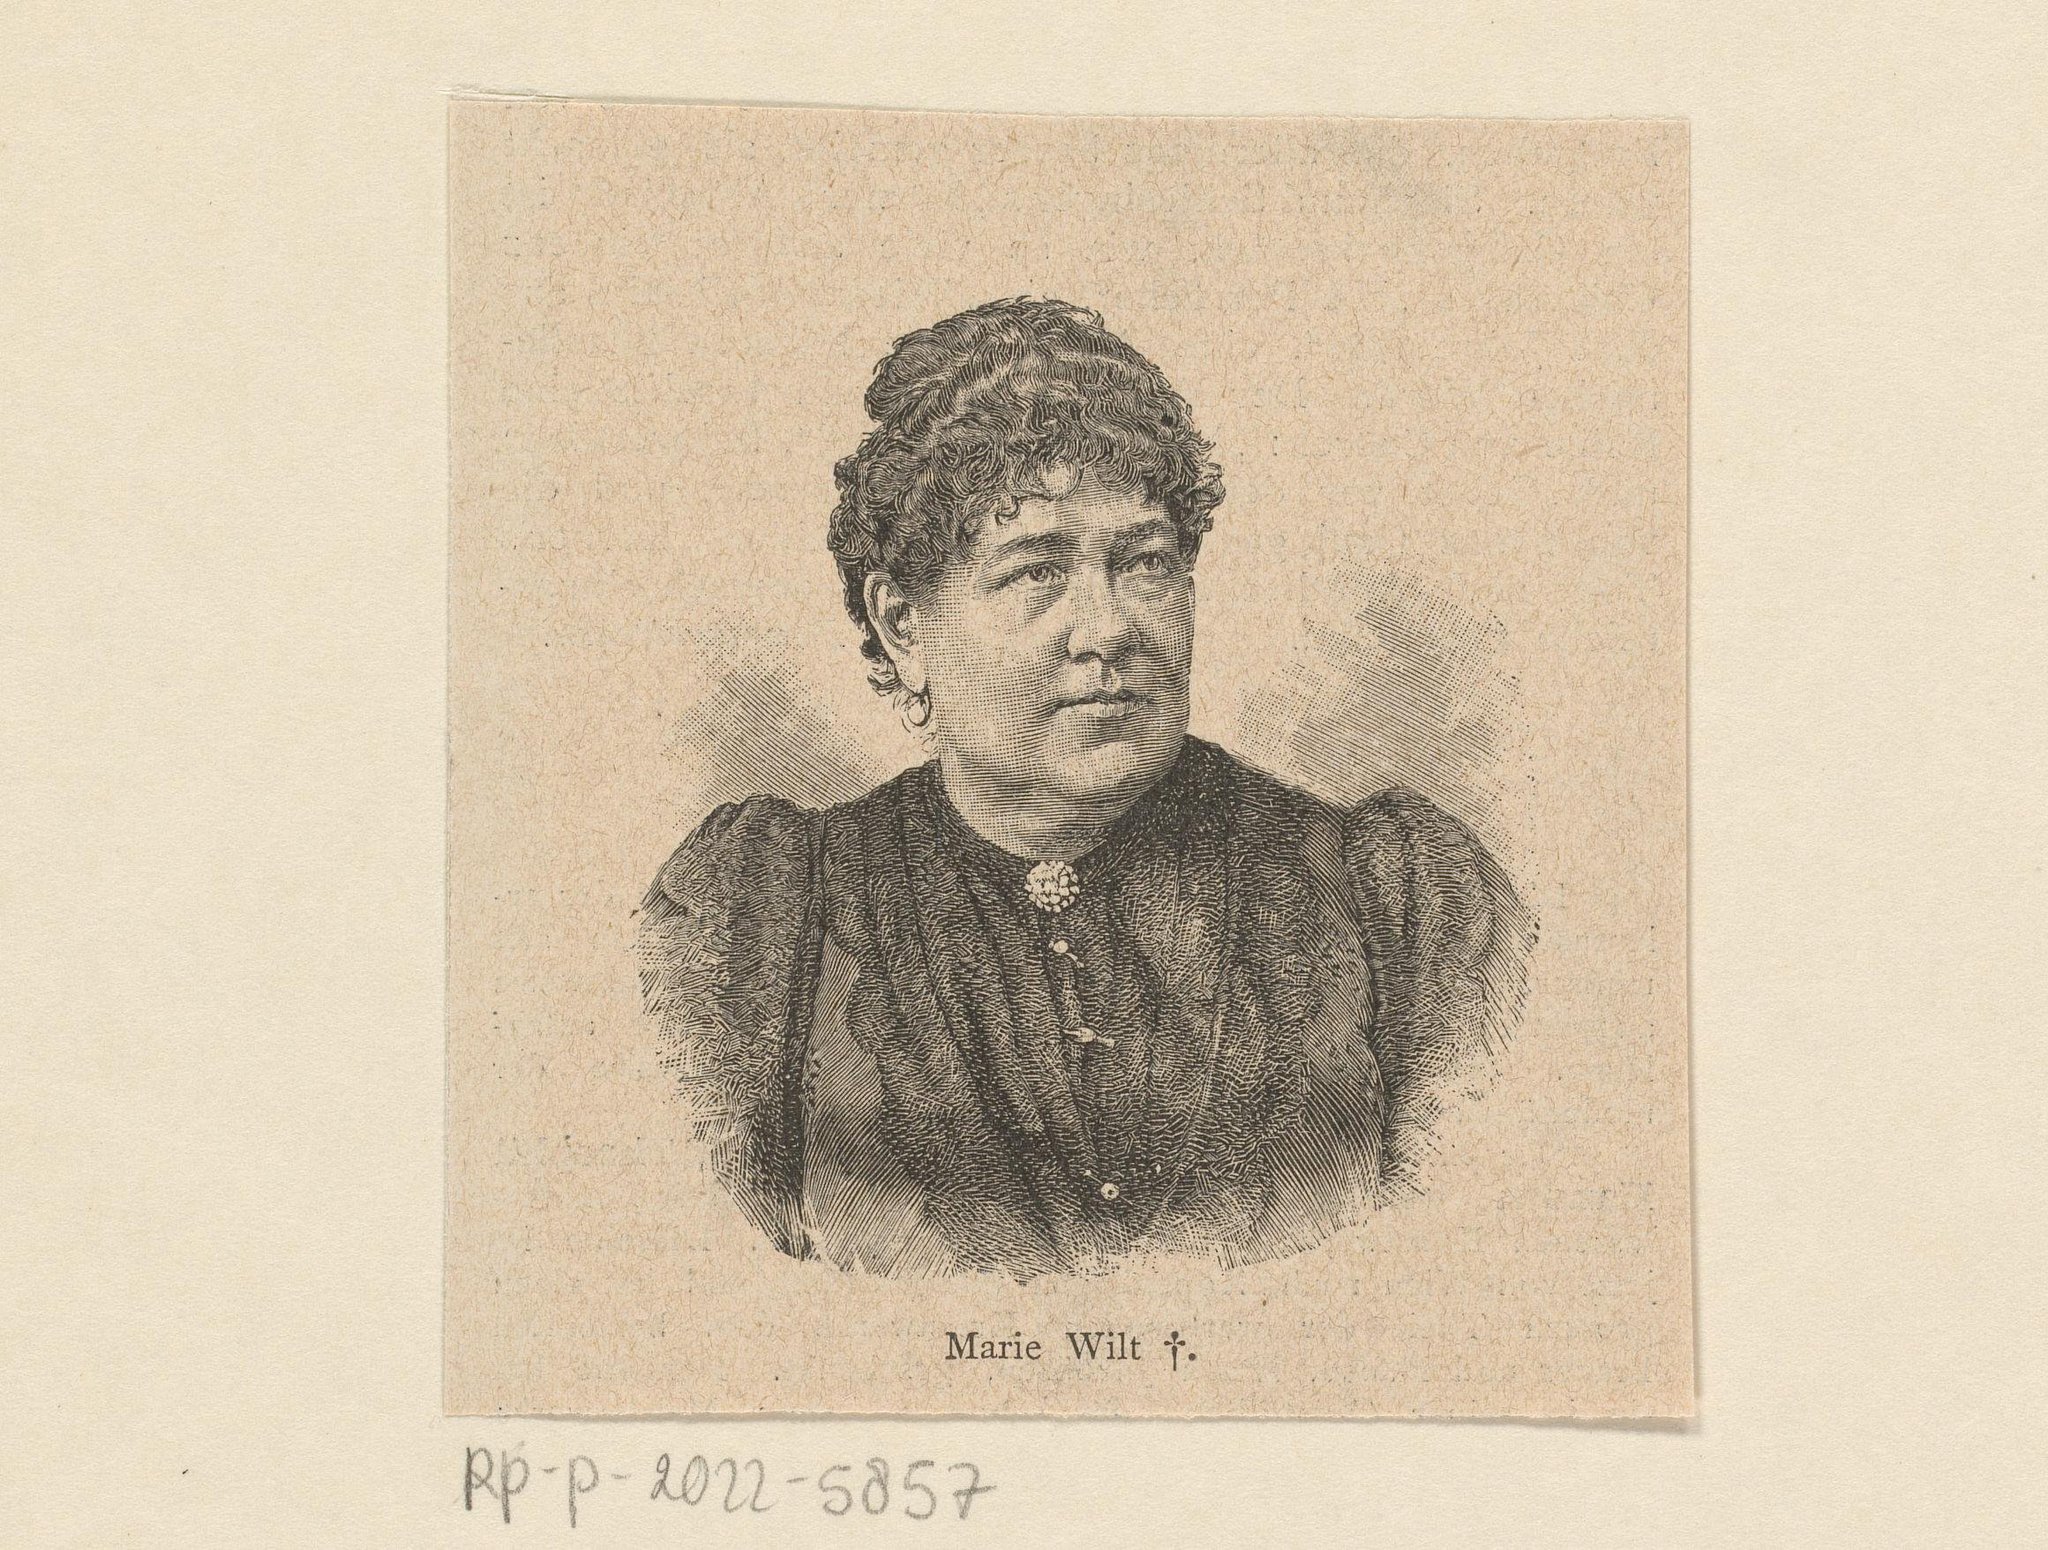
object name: book illustration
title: Portret van Marie Wilt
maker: Anonymous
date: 1891-1892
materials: paper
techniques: letterpress printing, engraving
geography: germany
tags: vienna, historical persons - bb - woman, opera-singer (female)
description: Prent waarschijnlijk uit: Moderne Kunst 6, nr. 3 (1891-1892).